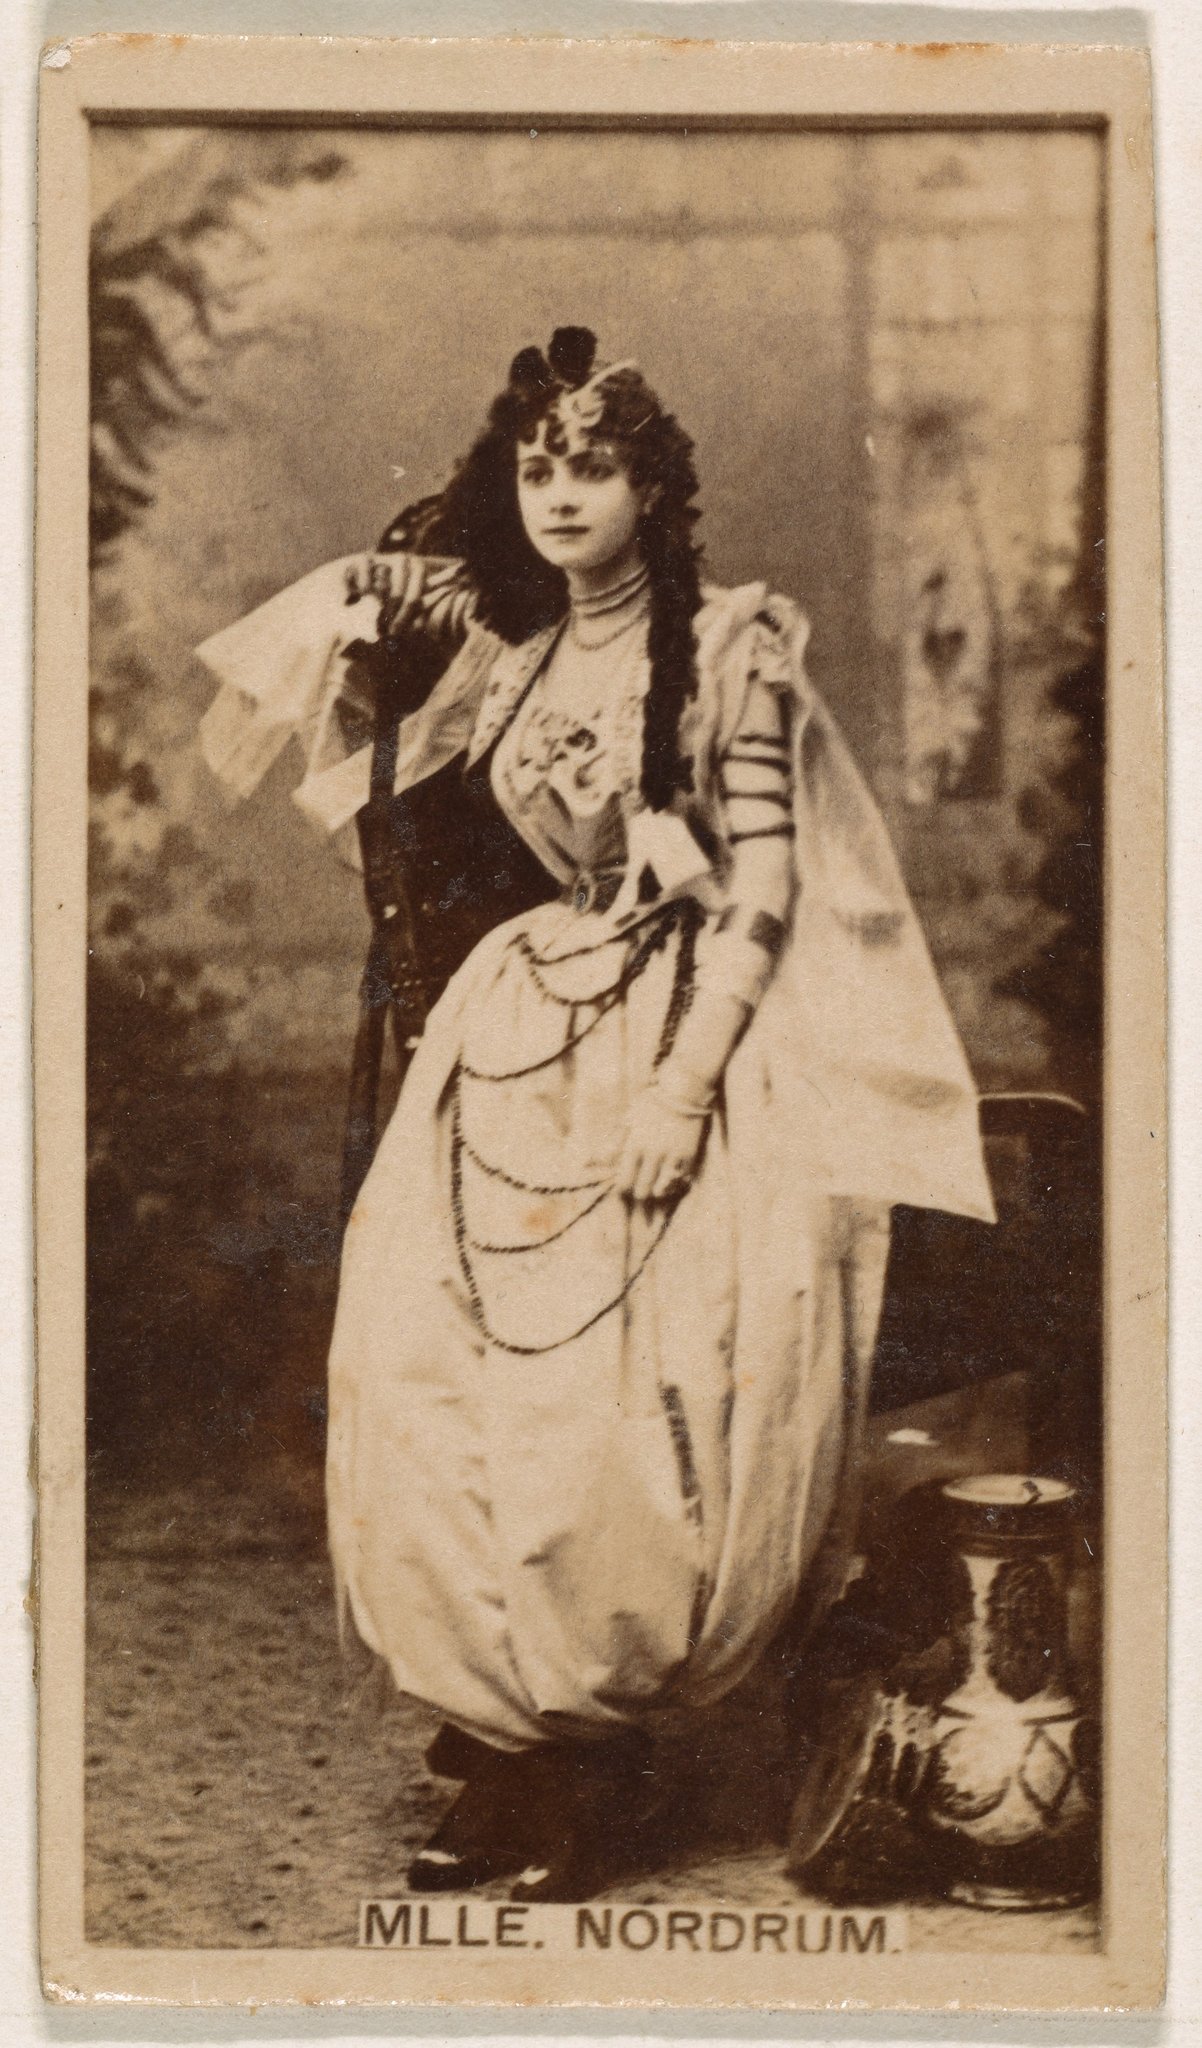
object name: photograph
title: Mlle. Nordrum, from the Actresses series (N245) issued by Kinney Brothers to promote Sweet Caporal Cigarettes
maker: kinney brothers tobacco company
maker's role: publisher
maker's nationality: american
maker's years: 1869-2011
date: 1890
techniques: albumen silver print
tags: portraits,women,actresses